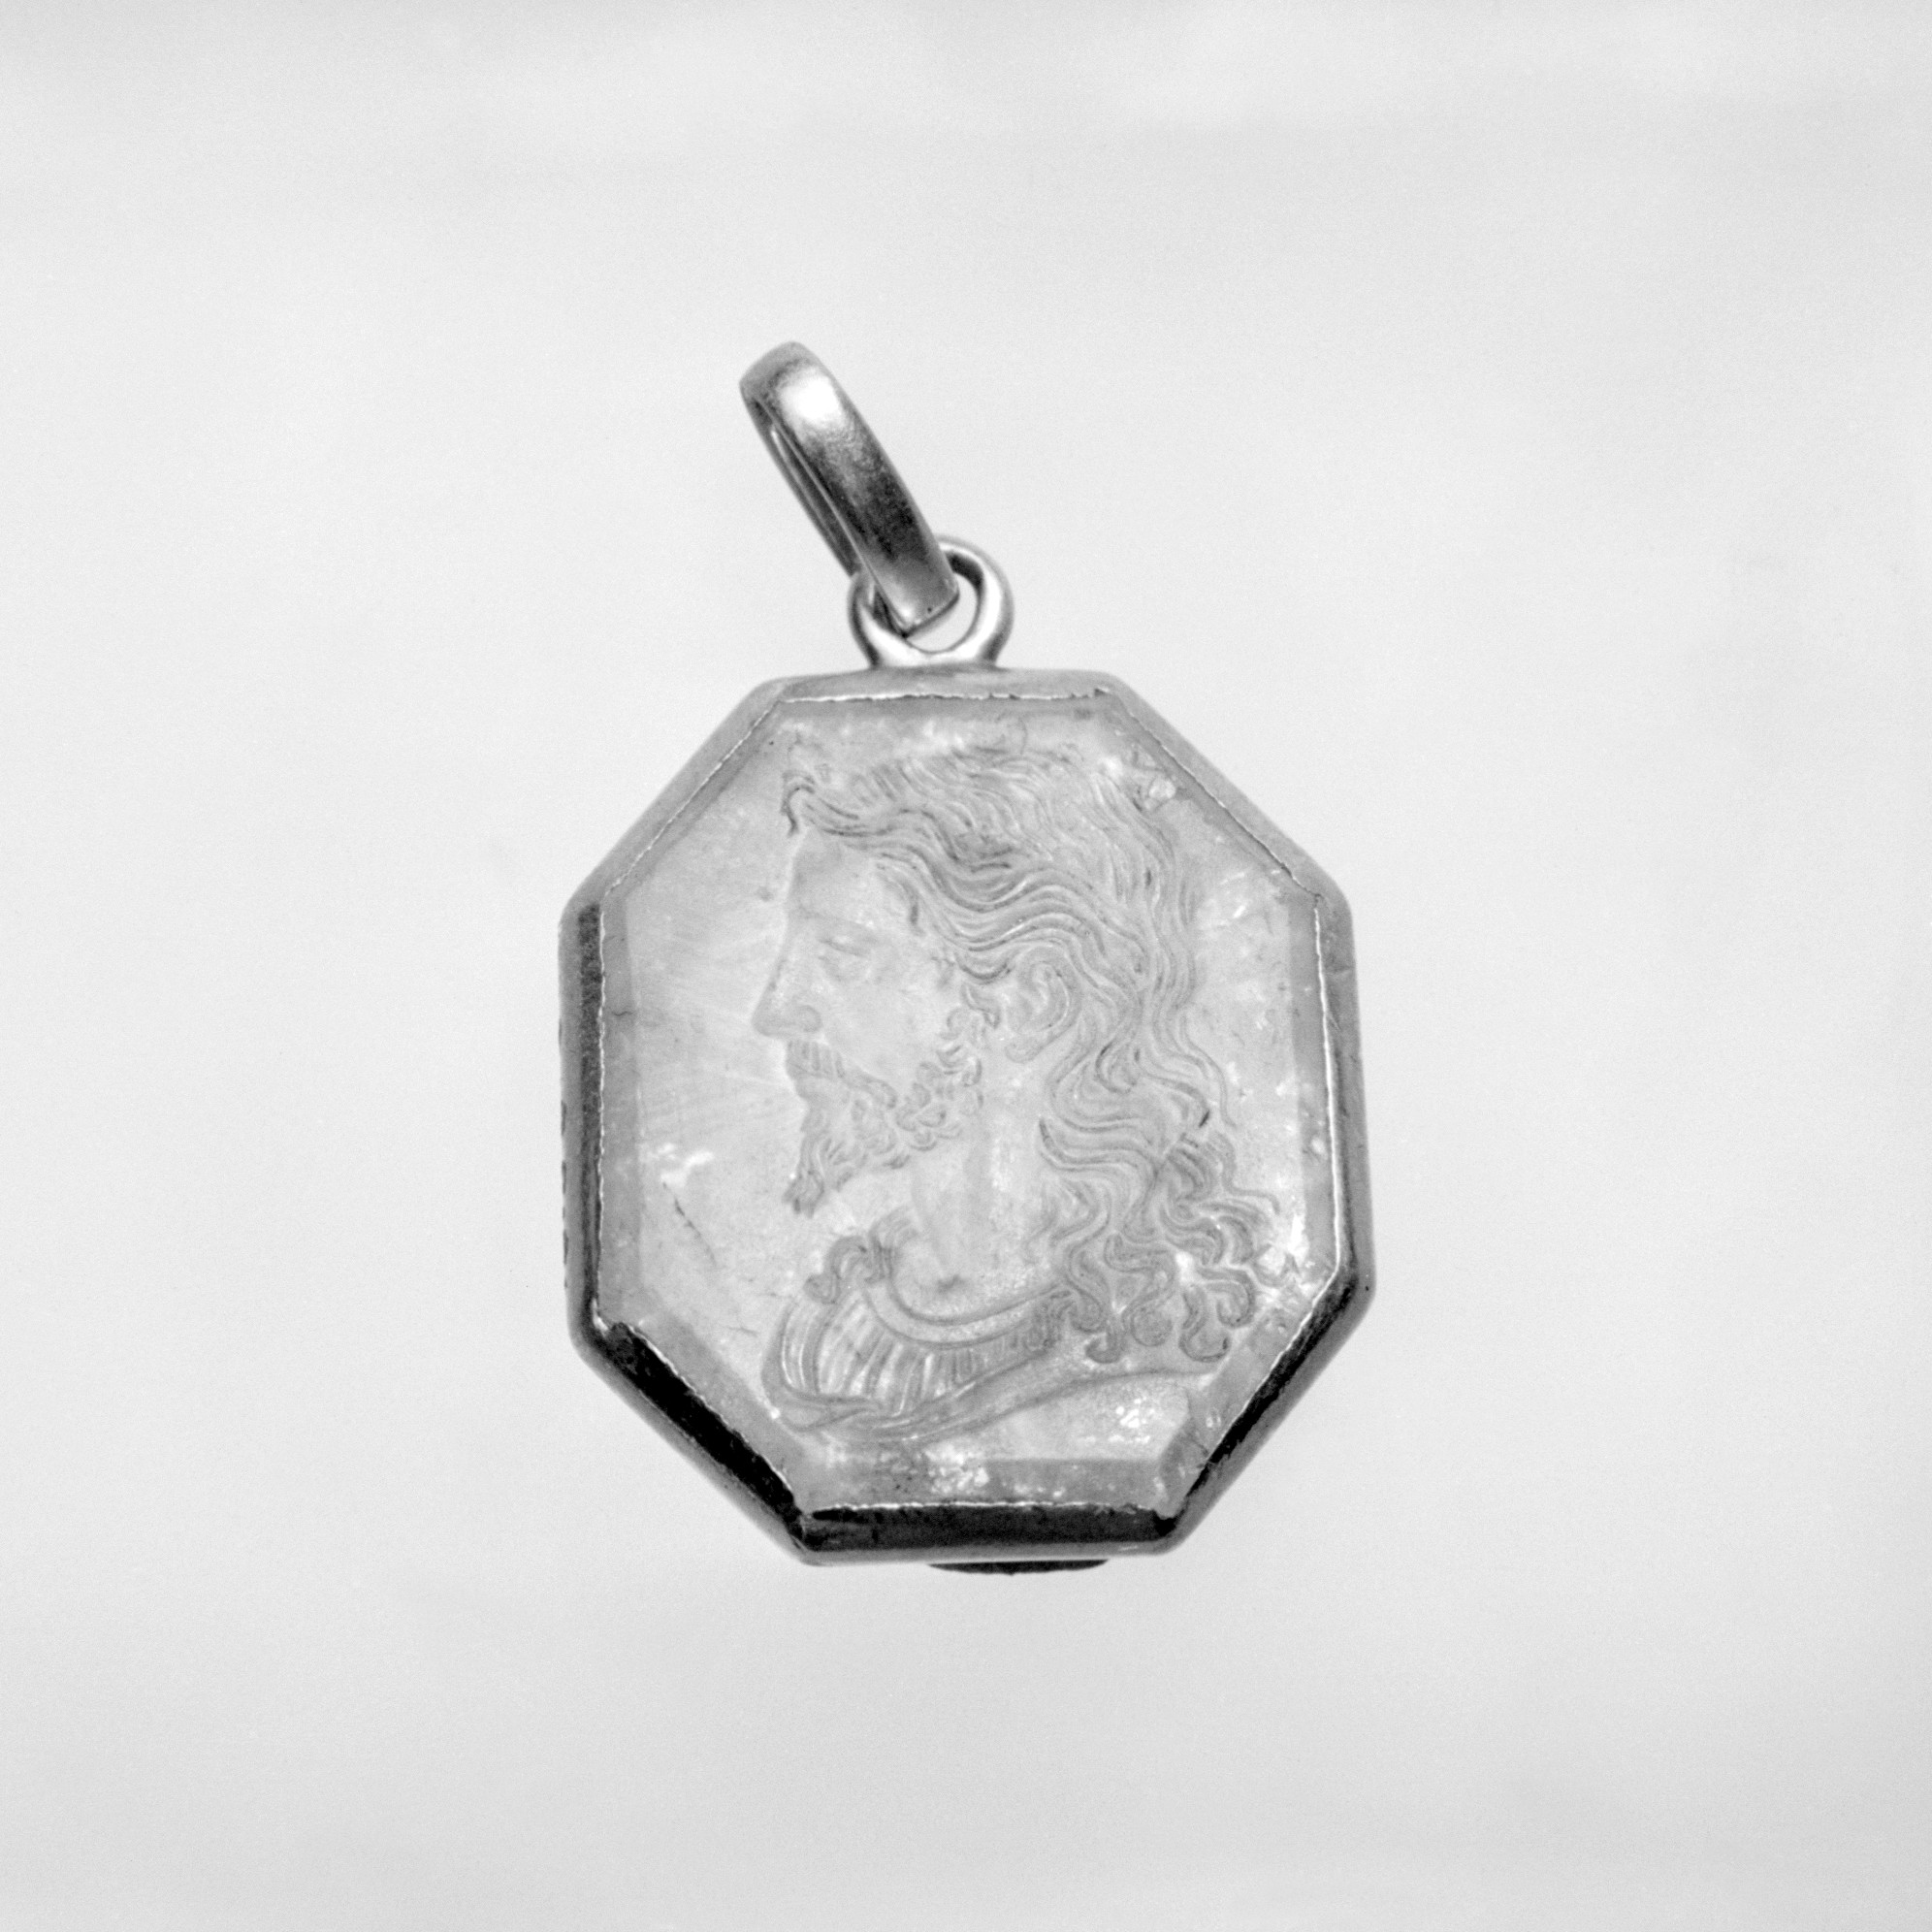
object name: pendant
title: Head of Christ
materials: gemstone, gold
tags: jesus